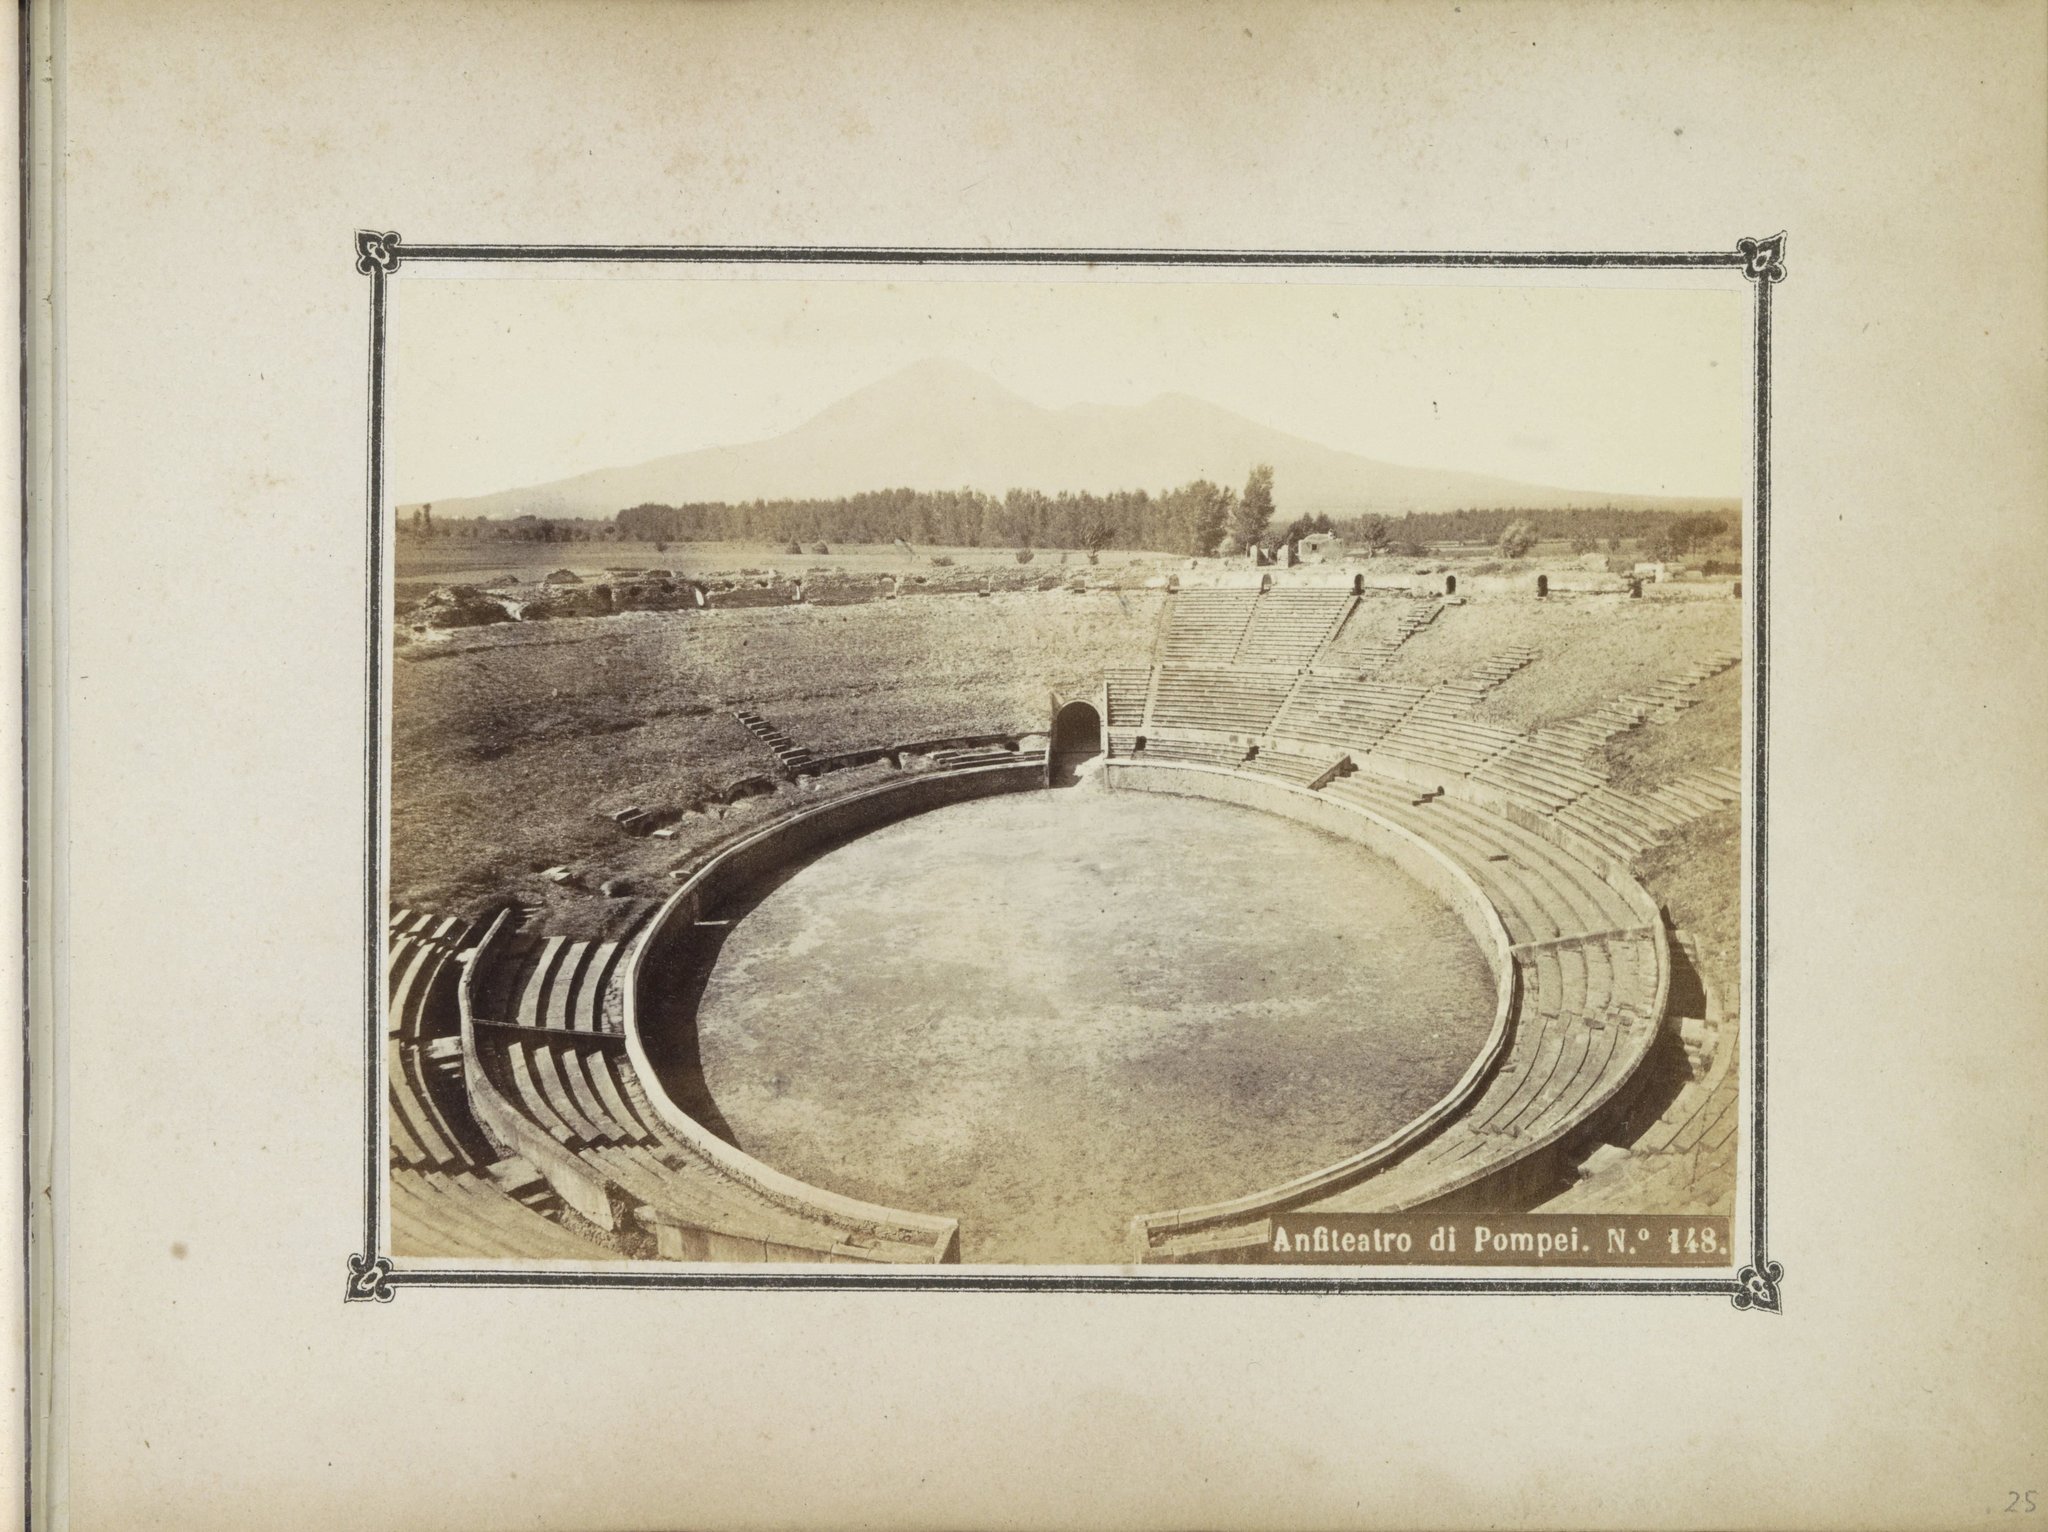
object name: album leaf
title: Interieur van het amfitheater in Pompeï met op de achtergrond de Vesuvius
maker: roberto rive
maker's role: fotograaf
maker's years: 1825-1868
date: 1860-1900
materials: paper, photographic support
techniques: albumen print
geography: pompeii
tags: theatre (building) - aa - open-air performances, excavation ~ archaeology, volcano, pompeii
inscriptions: number: ‘448’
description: Onderdeel van Fotoalbum met opnames van opgravingen in Pompeï door Roberto Rive.